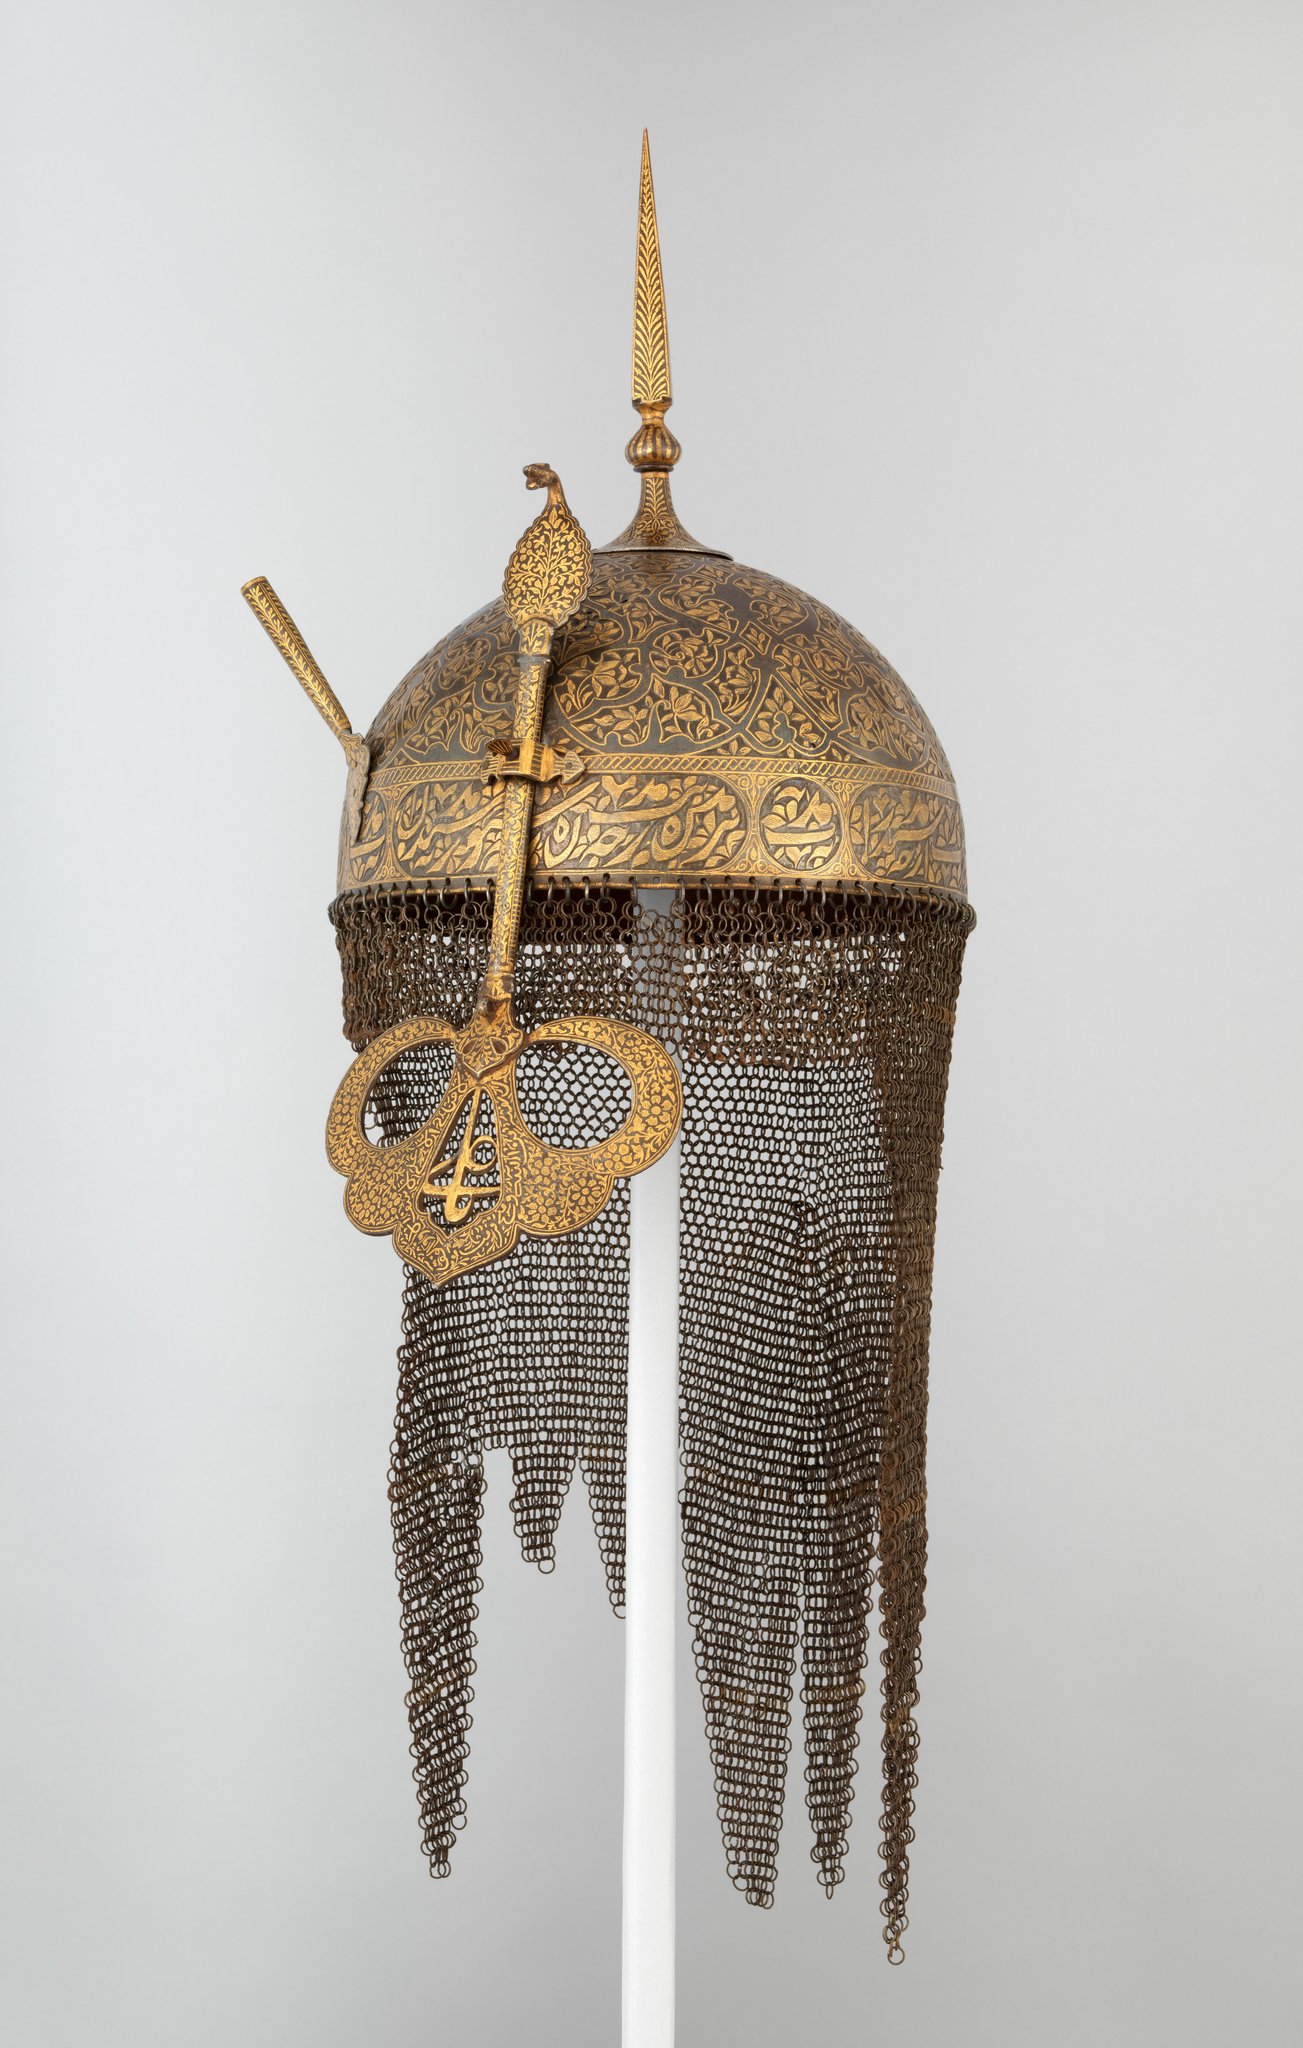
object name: helmet and arm guard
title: Helmet, Shield, and Arm Guard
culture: deccan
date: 1601-1900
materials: copper alloy, gold, steel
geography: india